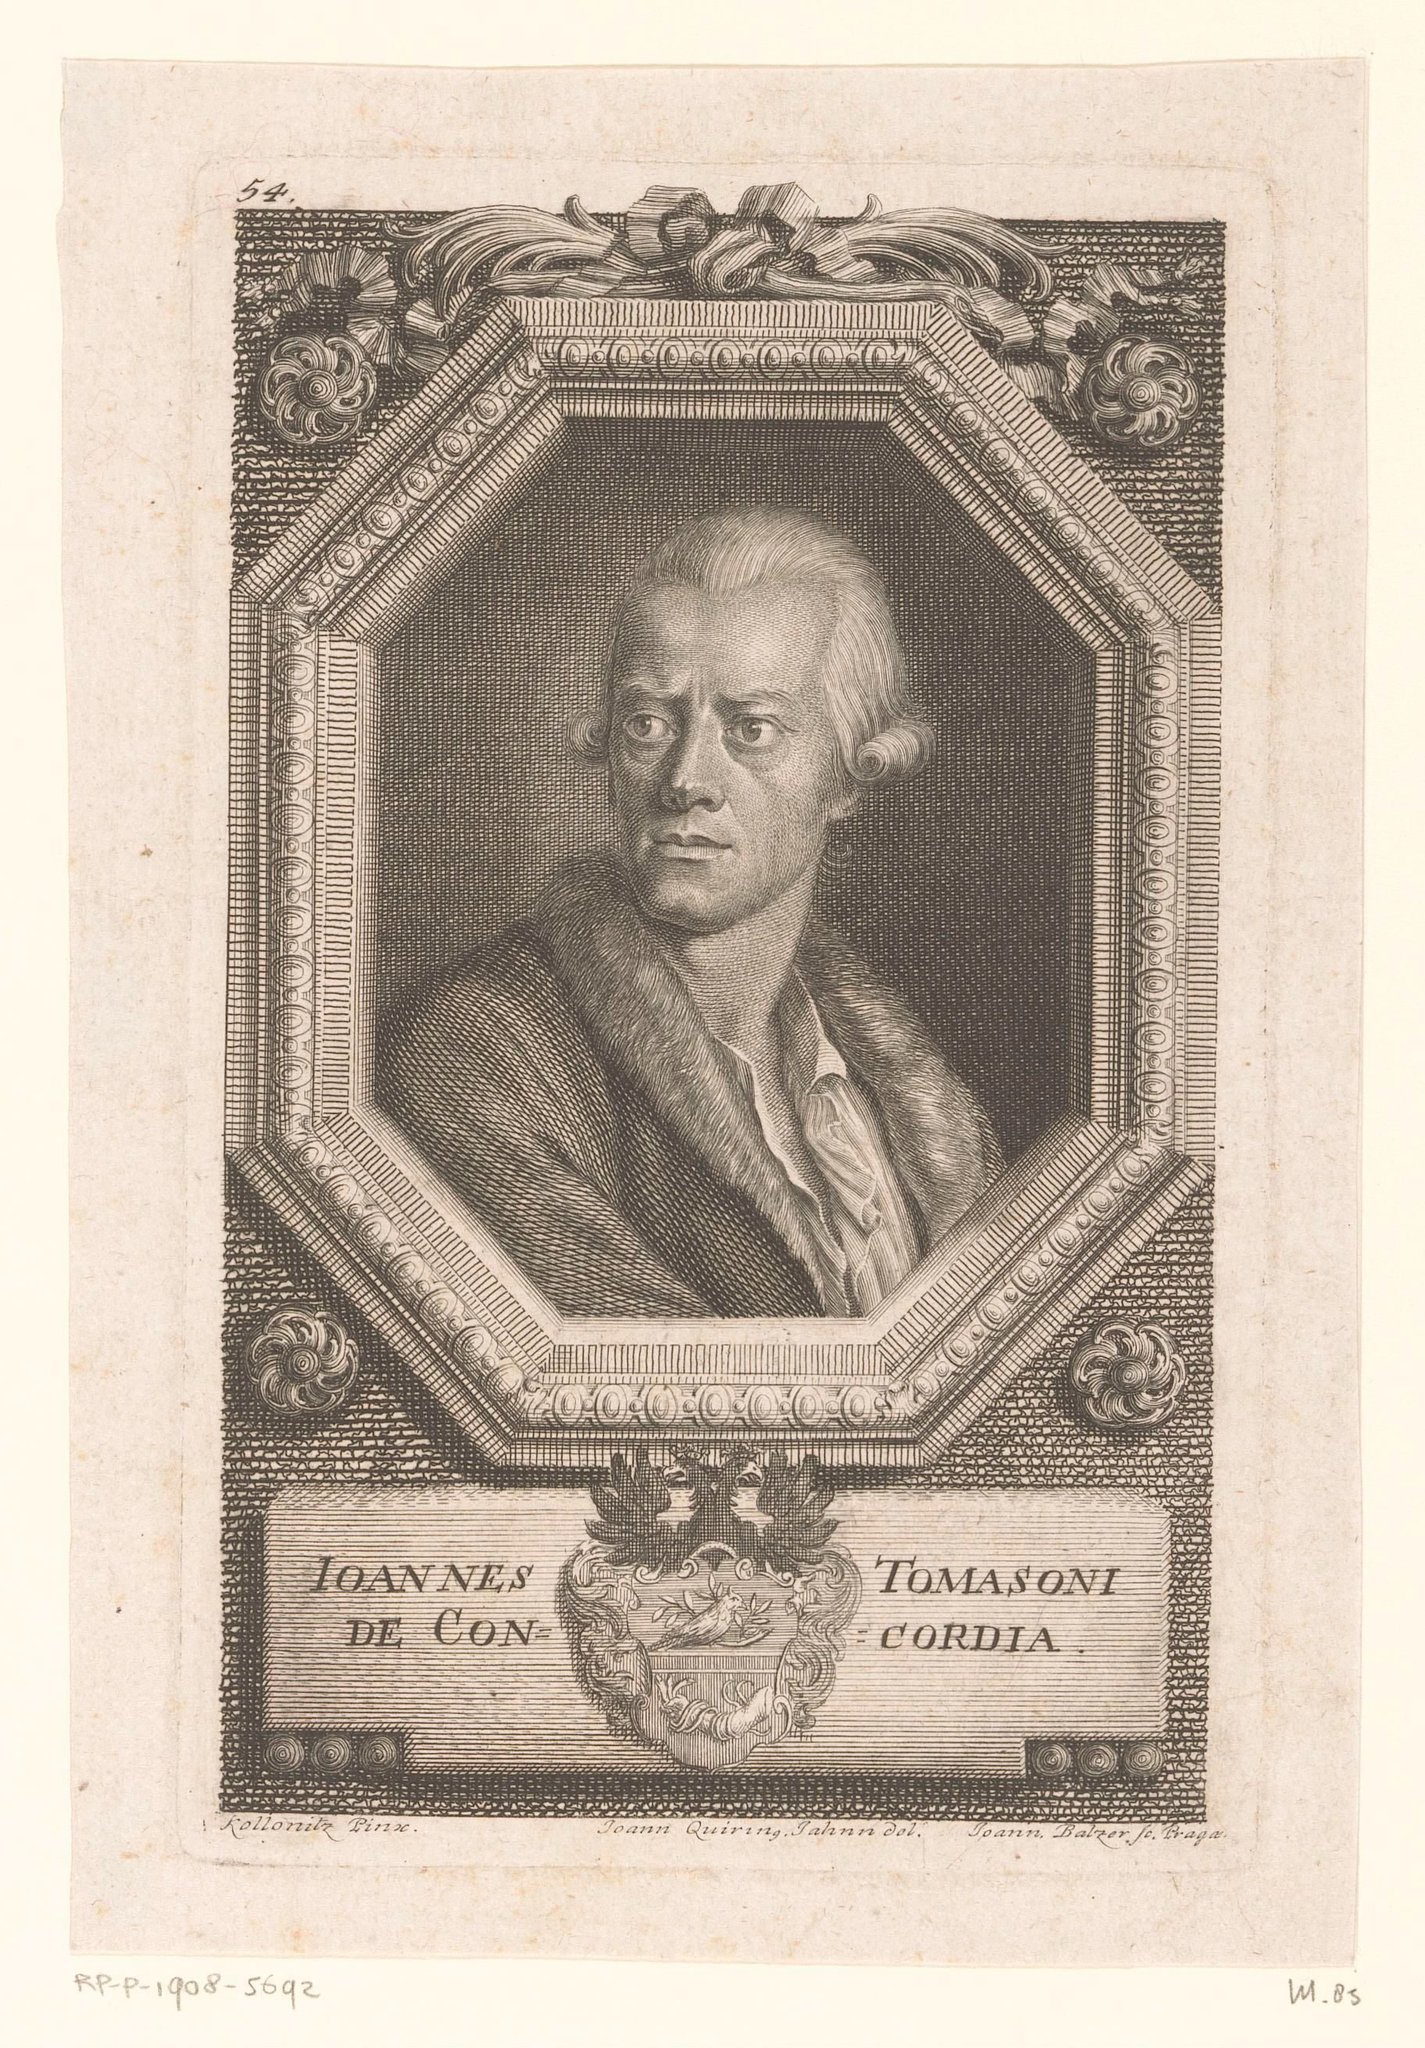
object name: print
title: Ioannes Tomasoni de Concordia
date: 1749-1799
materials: paper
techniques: engraving, etching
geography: prague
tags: prague, vienna, historical persons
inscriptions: collector's mark: Lugt 2228